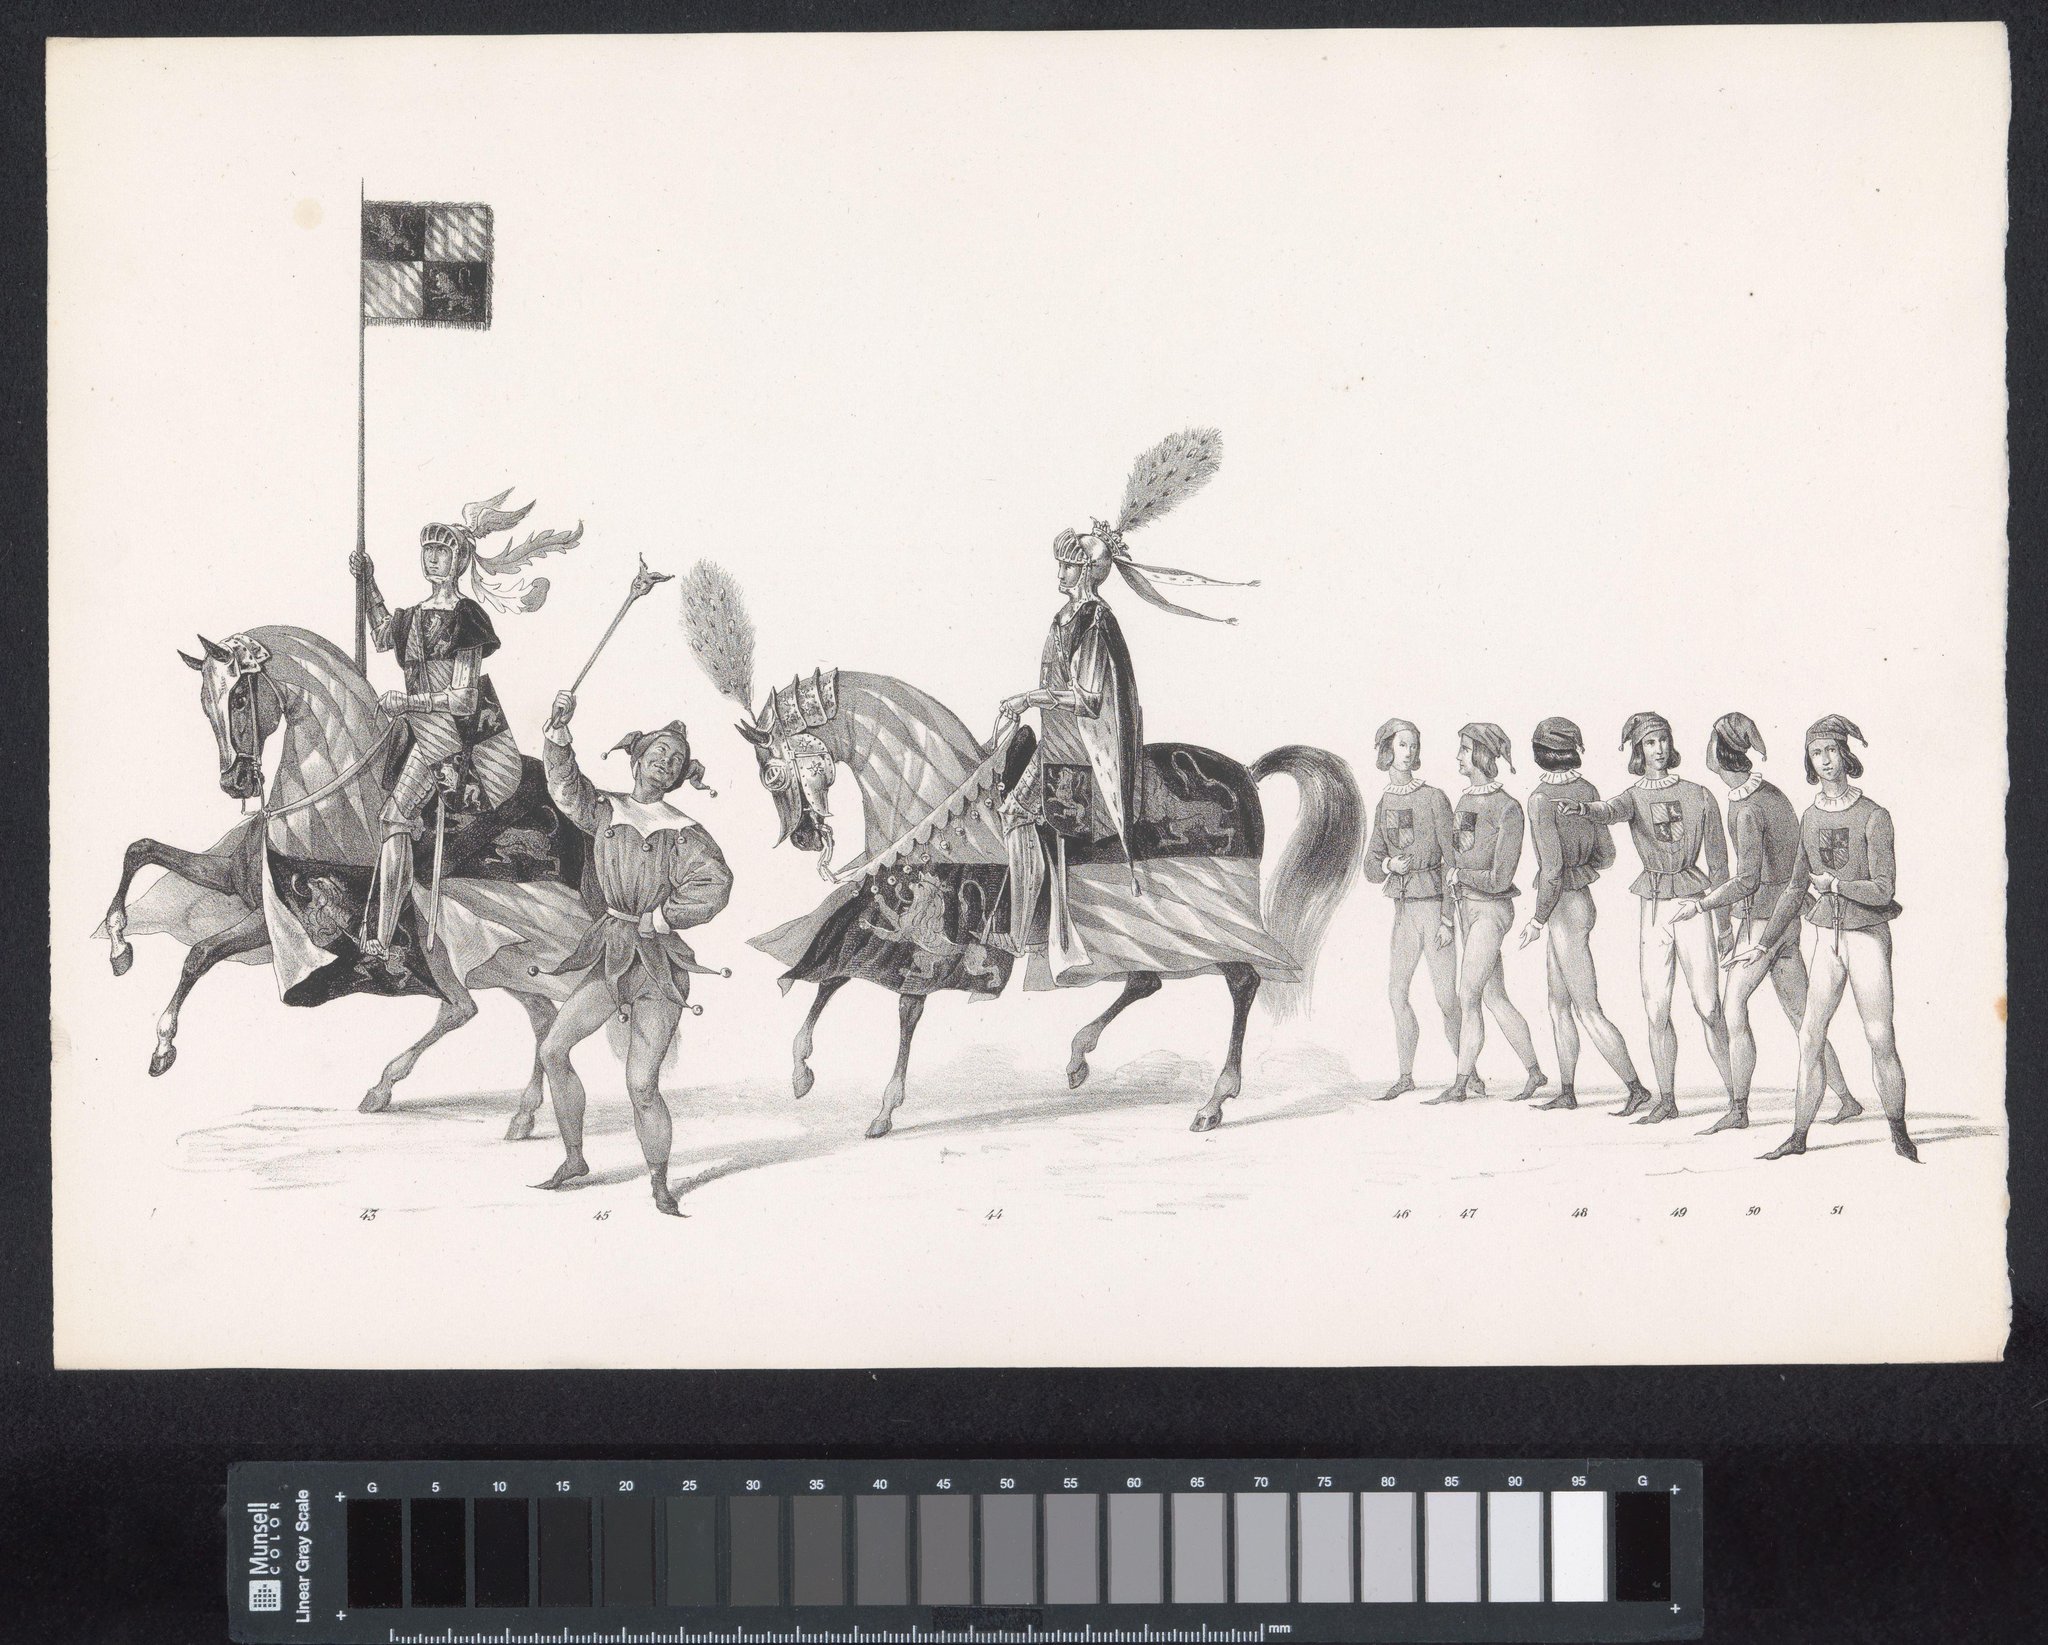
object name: print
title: De intogt van Hertog Jan van Beijeren binnen Leijden, Op den 18den Augustus 1420, in maskerade voorgesteld door H.H. Studenten der Leydsche Hoogeschool, Op den 8sten Februarij 1840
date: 1840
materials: paper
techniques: lithograph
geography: leiden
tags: jan van beieren, students' pageant, costumes used in pageants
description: Historische gekostumeerde optocht van de studenten van de Hogeschool van Leiden op 8 februari 1840. De optocht verbeeldt de intocht van hertog Jan van Beieren te Leiden op 18 augustus 1420. Zevende plaat in een serie van negentien ongenummerde platen, met de groepen genummerd 43-51.